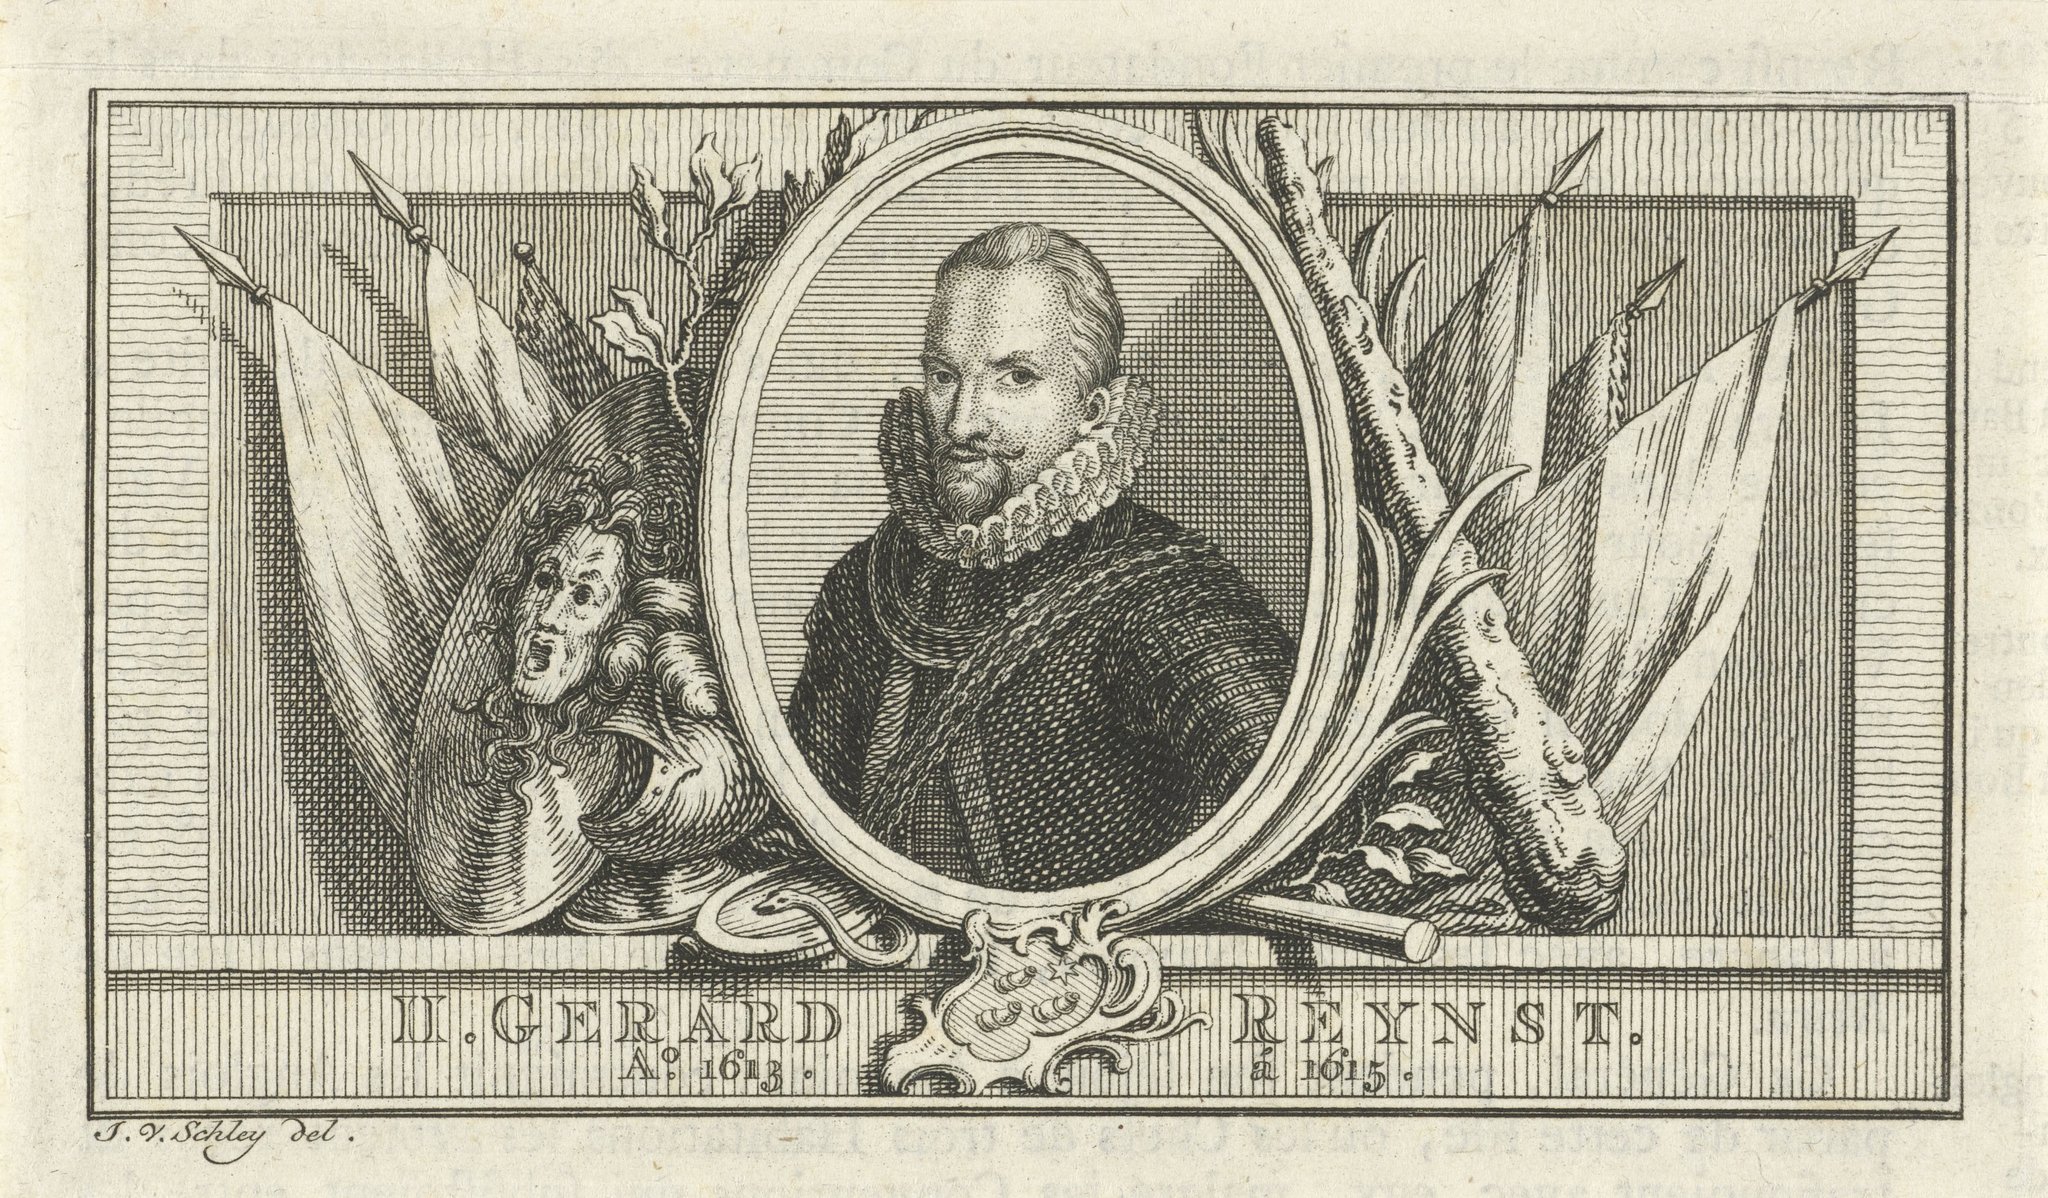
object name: print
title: Portret van Gerard Reynst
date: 1763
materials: paper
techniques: engraving, etching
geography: the hague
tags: invidia (envy) as roman personification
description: Portret van Gerard Reynst, gouverneur-generaal van het voormalige Nederlands Oost-Indië van 1613 tot 1615. Naast de omlijsting een knuppel, slang, de personificatie van Nijd, een palmtak en een olijftak.